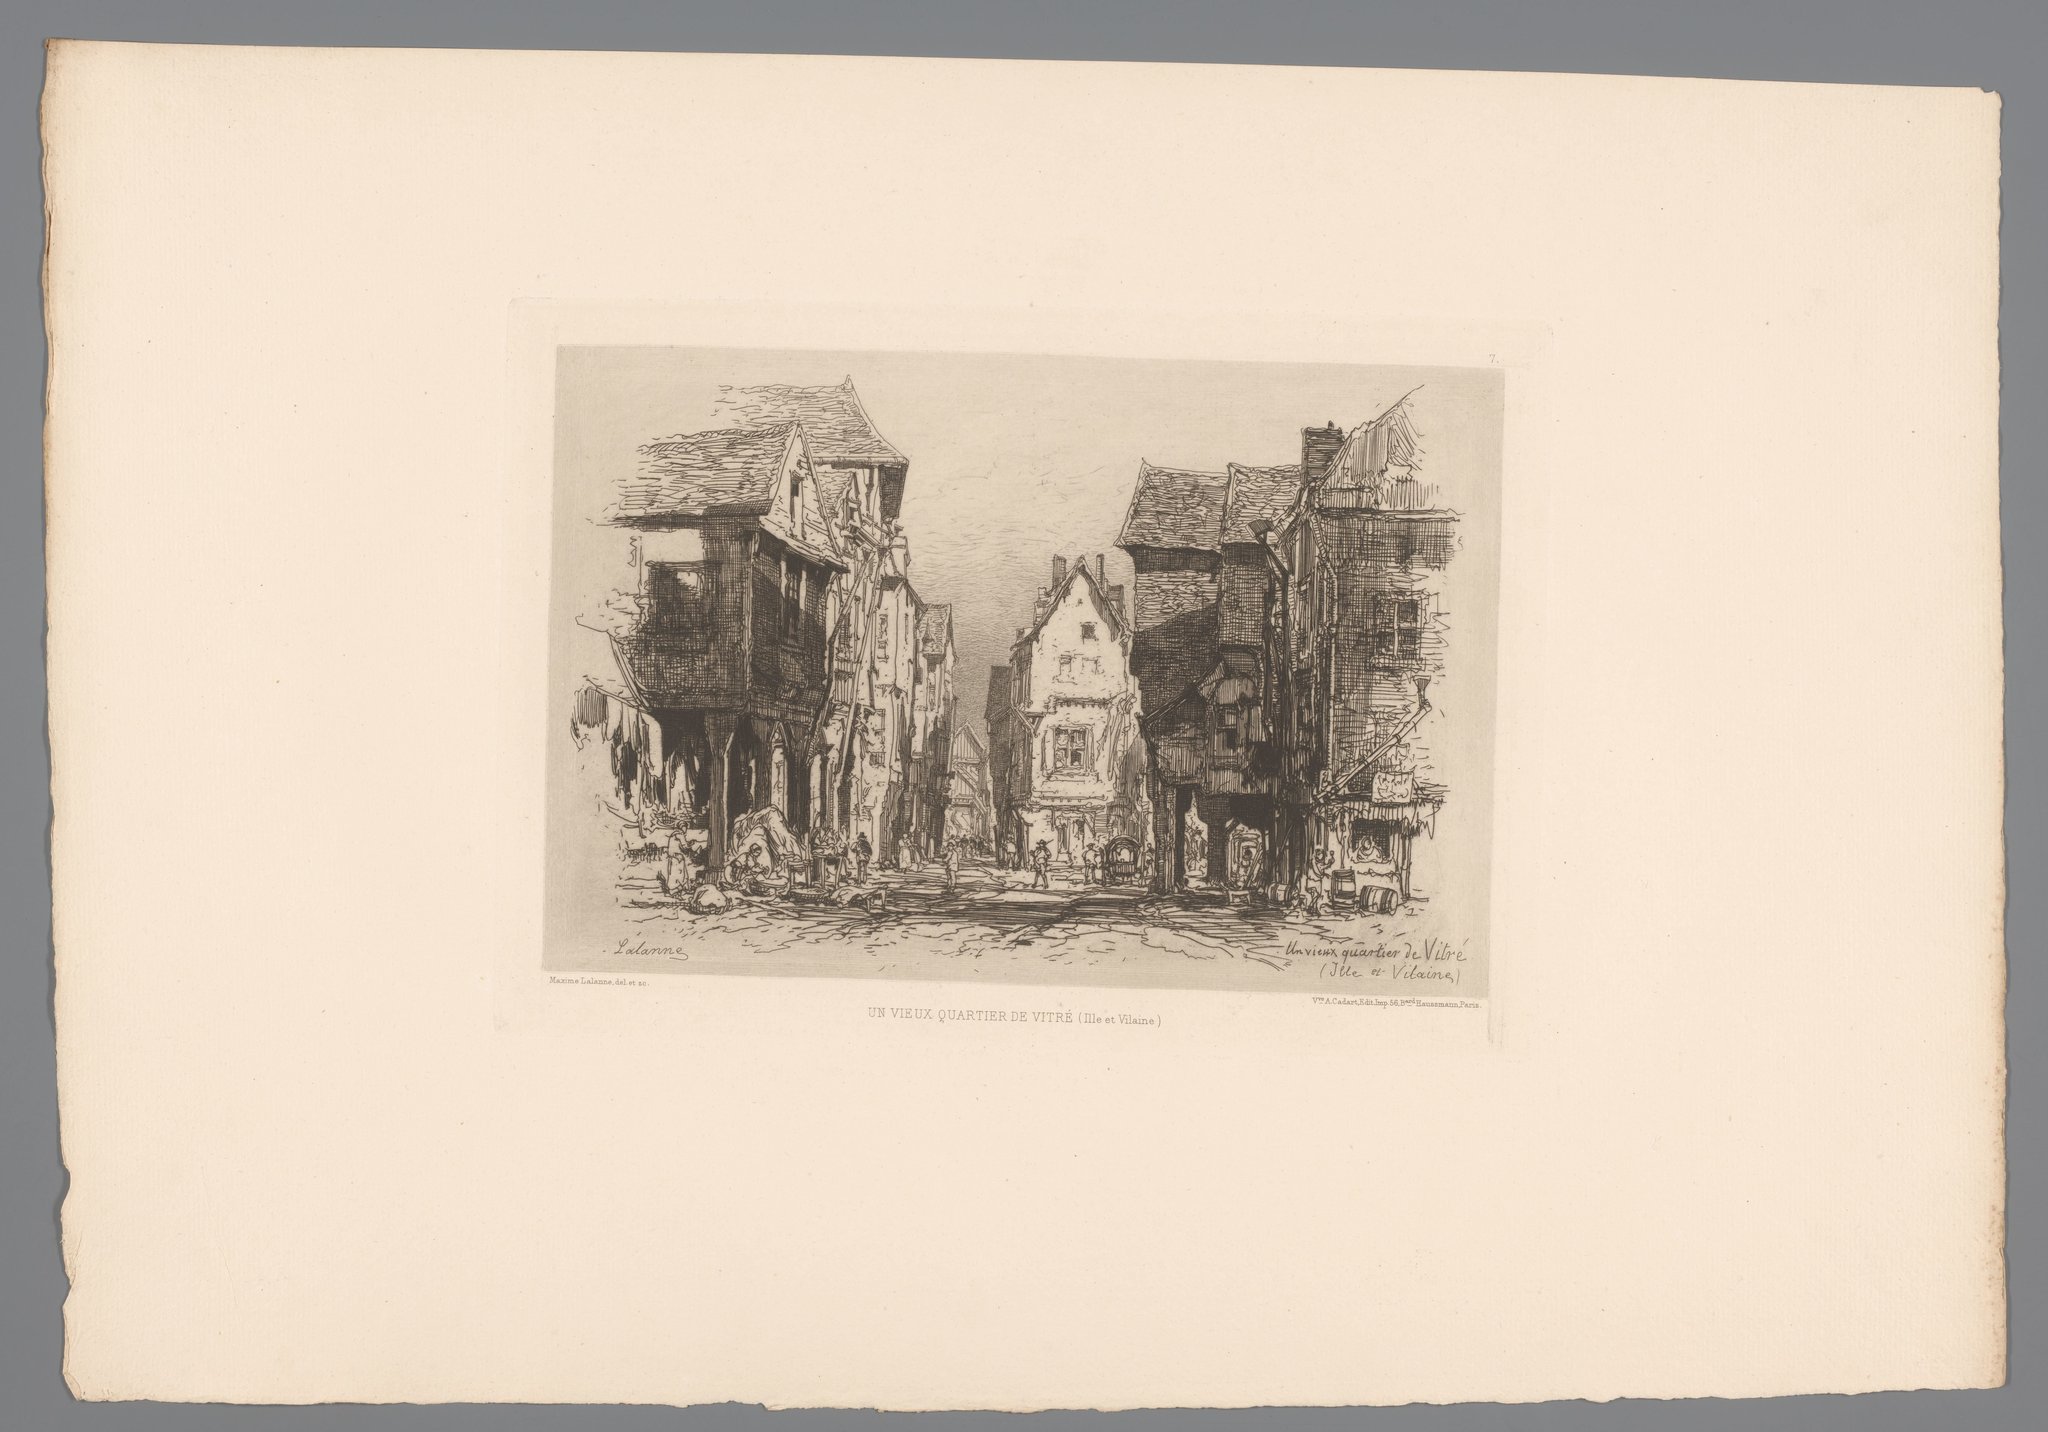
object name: print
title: Franse etsen uit 1879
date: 1879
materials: paper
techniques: drypoint, etching, intaglio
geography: paris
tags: city-view in general; 'veduta'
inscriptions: watermark, collector's mark: Lugt 2228, collector's mark: Lugt 2760, collector's mark: ‘AFE v S’